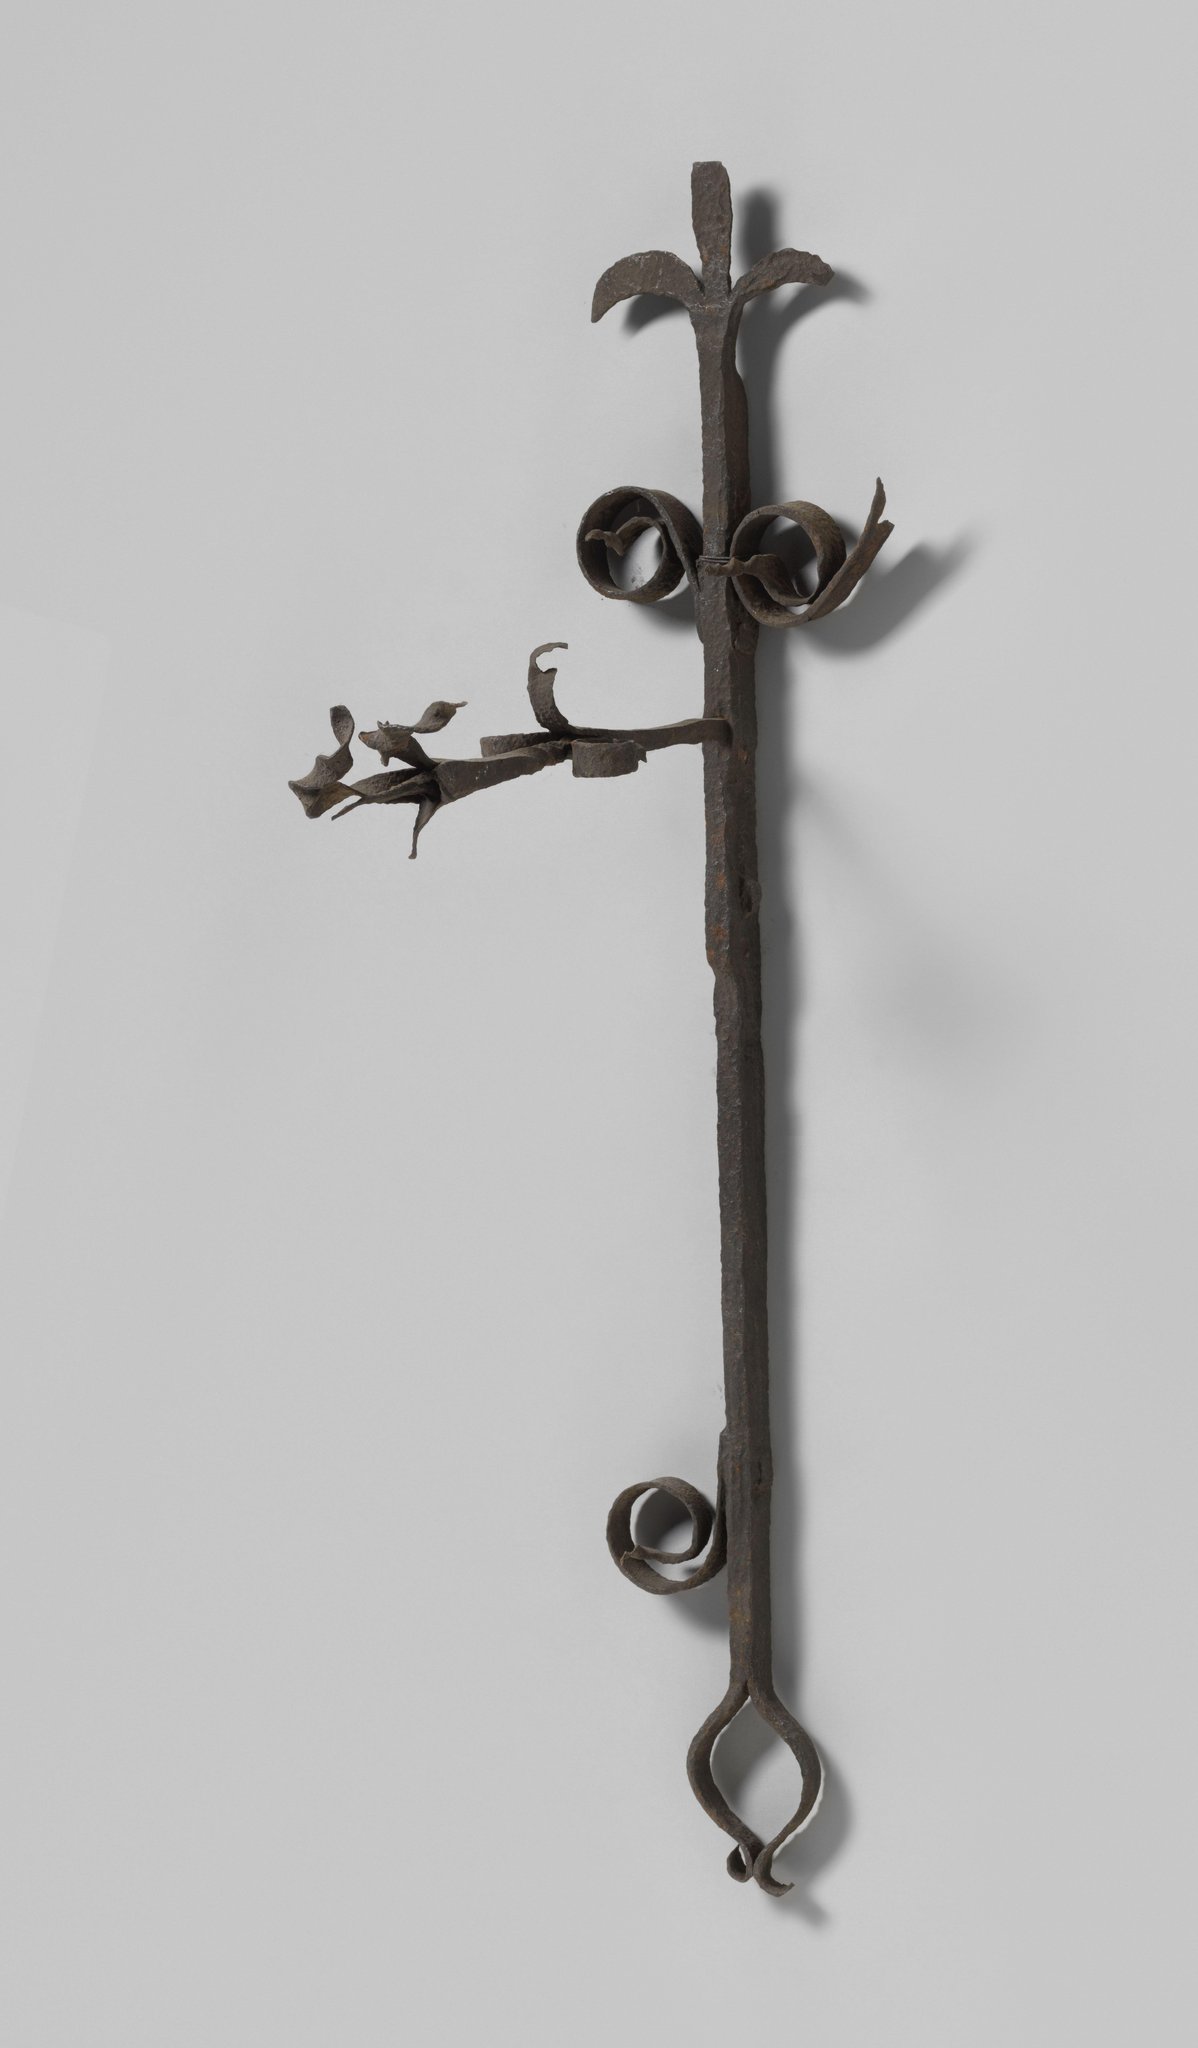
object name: anchor tie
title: Schieter van een muuranker van een huis te Arnhem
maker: Anonymous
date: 1600-1625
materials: iron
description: Smeedijzeren schieter van een muuranker, afkomstig van een huis te Arnhem.